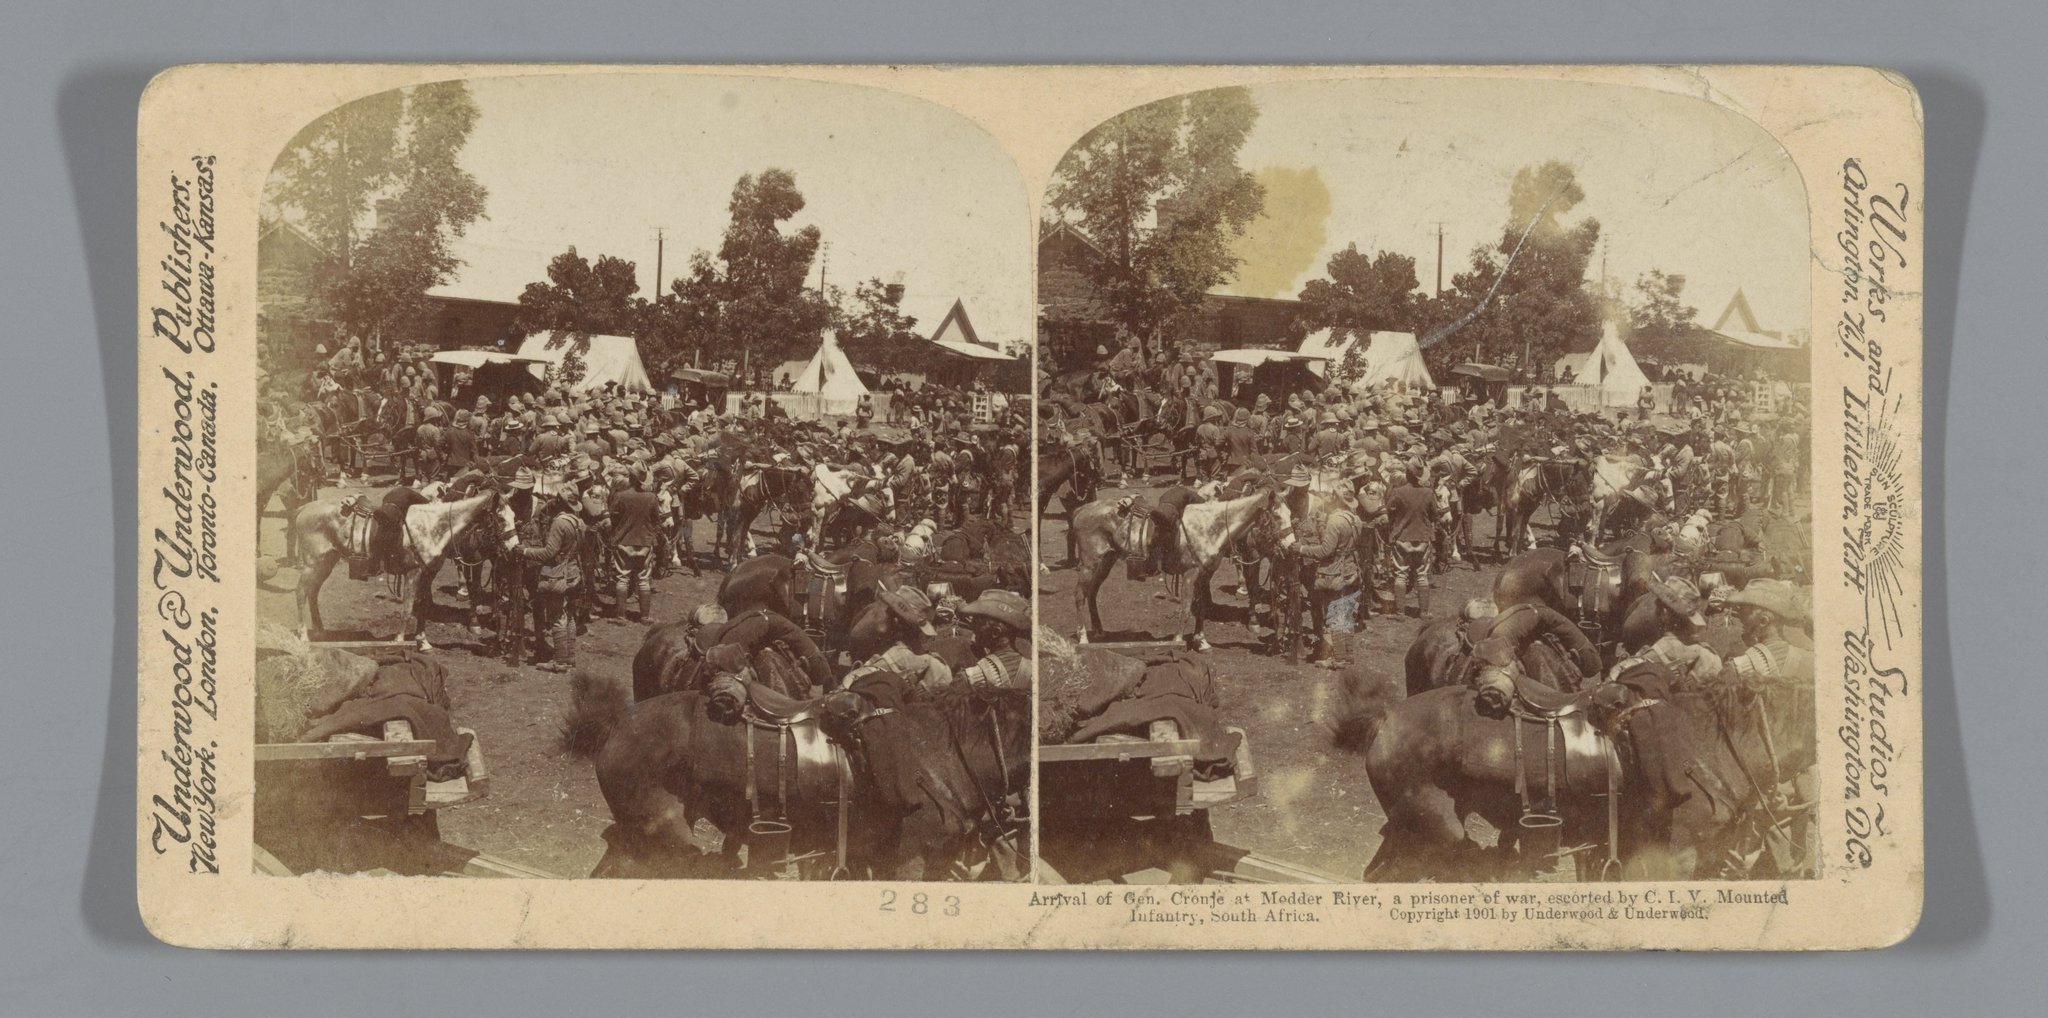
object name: stereograph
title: Piet Cronjé, generaal van de Boeren, is gevangen door de Britten bij de Modderrivier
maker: Anonymous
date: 1901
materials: cardboard, paper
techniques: albumen print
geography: new york city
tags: prisoner of war (after the battle)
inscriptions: number: ‘283’, copyright notice: ‘Copyright 1901 by Underwood & Underwood.’, inscription, inscription: ‘Works and Studios ~/ Arlington, N.J. Littleton, N.H. Washington, D.C.’